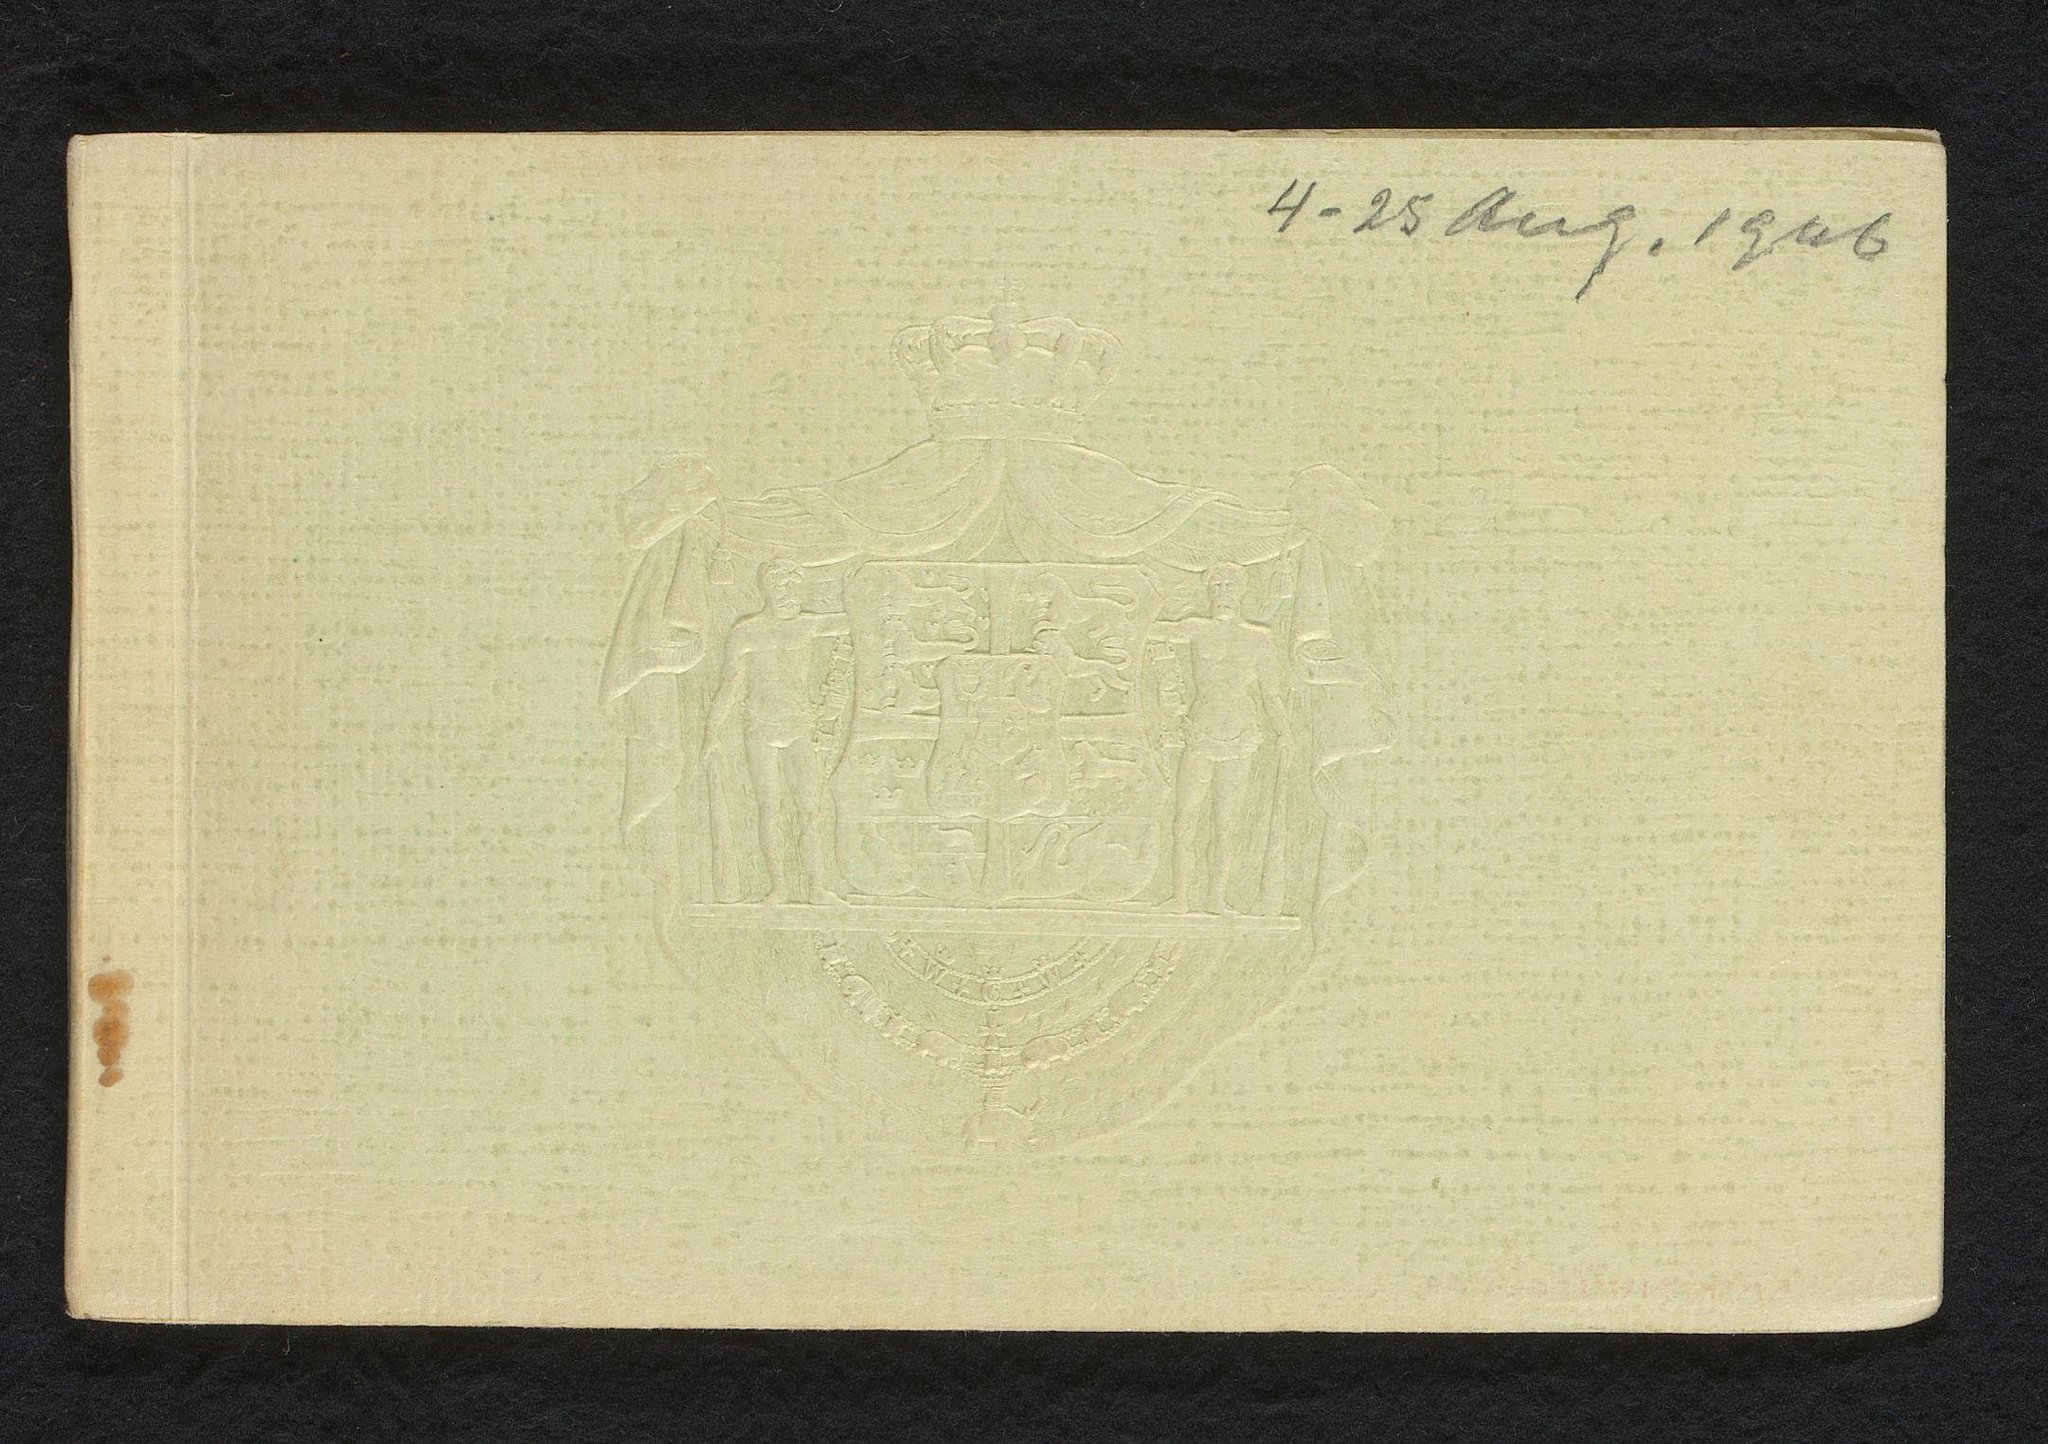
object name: album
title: Af Københavns historie / Of the history of Copenhagen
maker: Anonymous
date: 1944-1946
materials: cardboard, paper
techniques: blind stamped, letterpress printing, rotogravure, stapling, writing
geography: denmark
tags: coat of arms (as symbol of the state, etc.), city-view, and landscape with man-made constructions (+ city(-scape) with figures, staffage), copenhagen (city)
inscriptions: inscription: ‘4-25 aug. 1946’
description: Album bestaande uit 61 pagina's met vijfentwintig voorstellingen van attracties in Kopenhagen, historische toelichtingen in het Deens en Engels, openingstijden en tramlijnen.